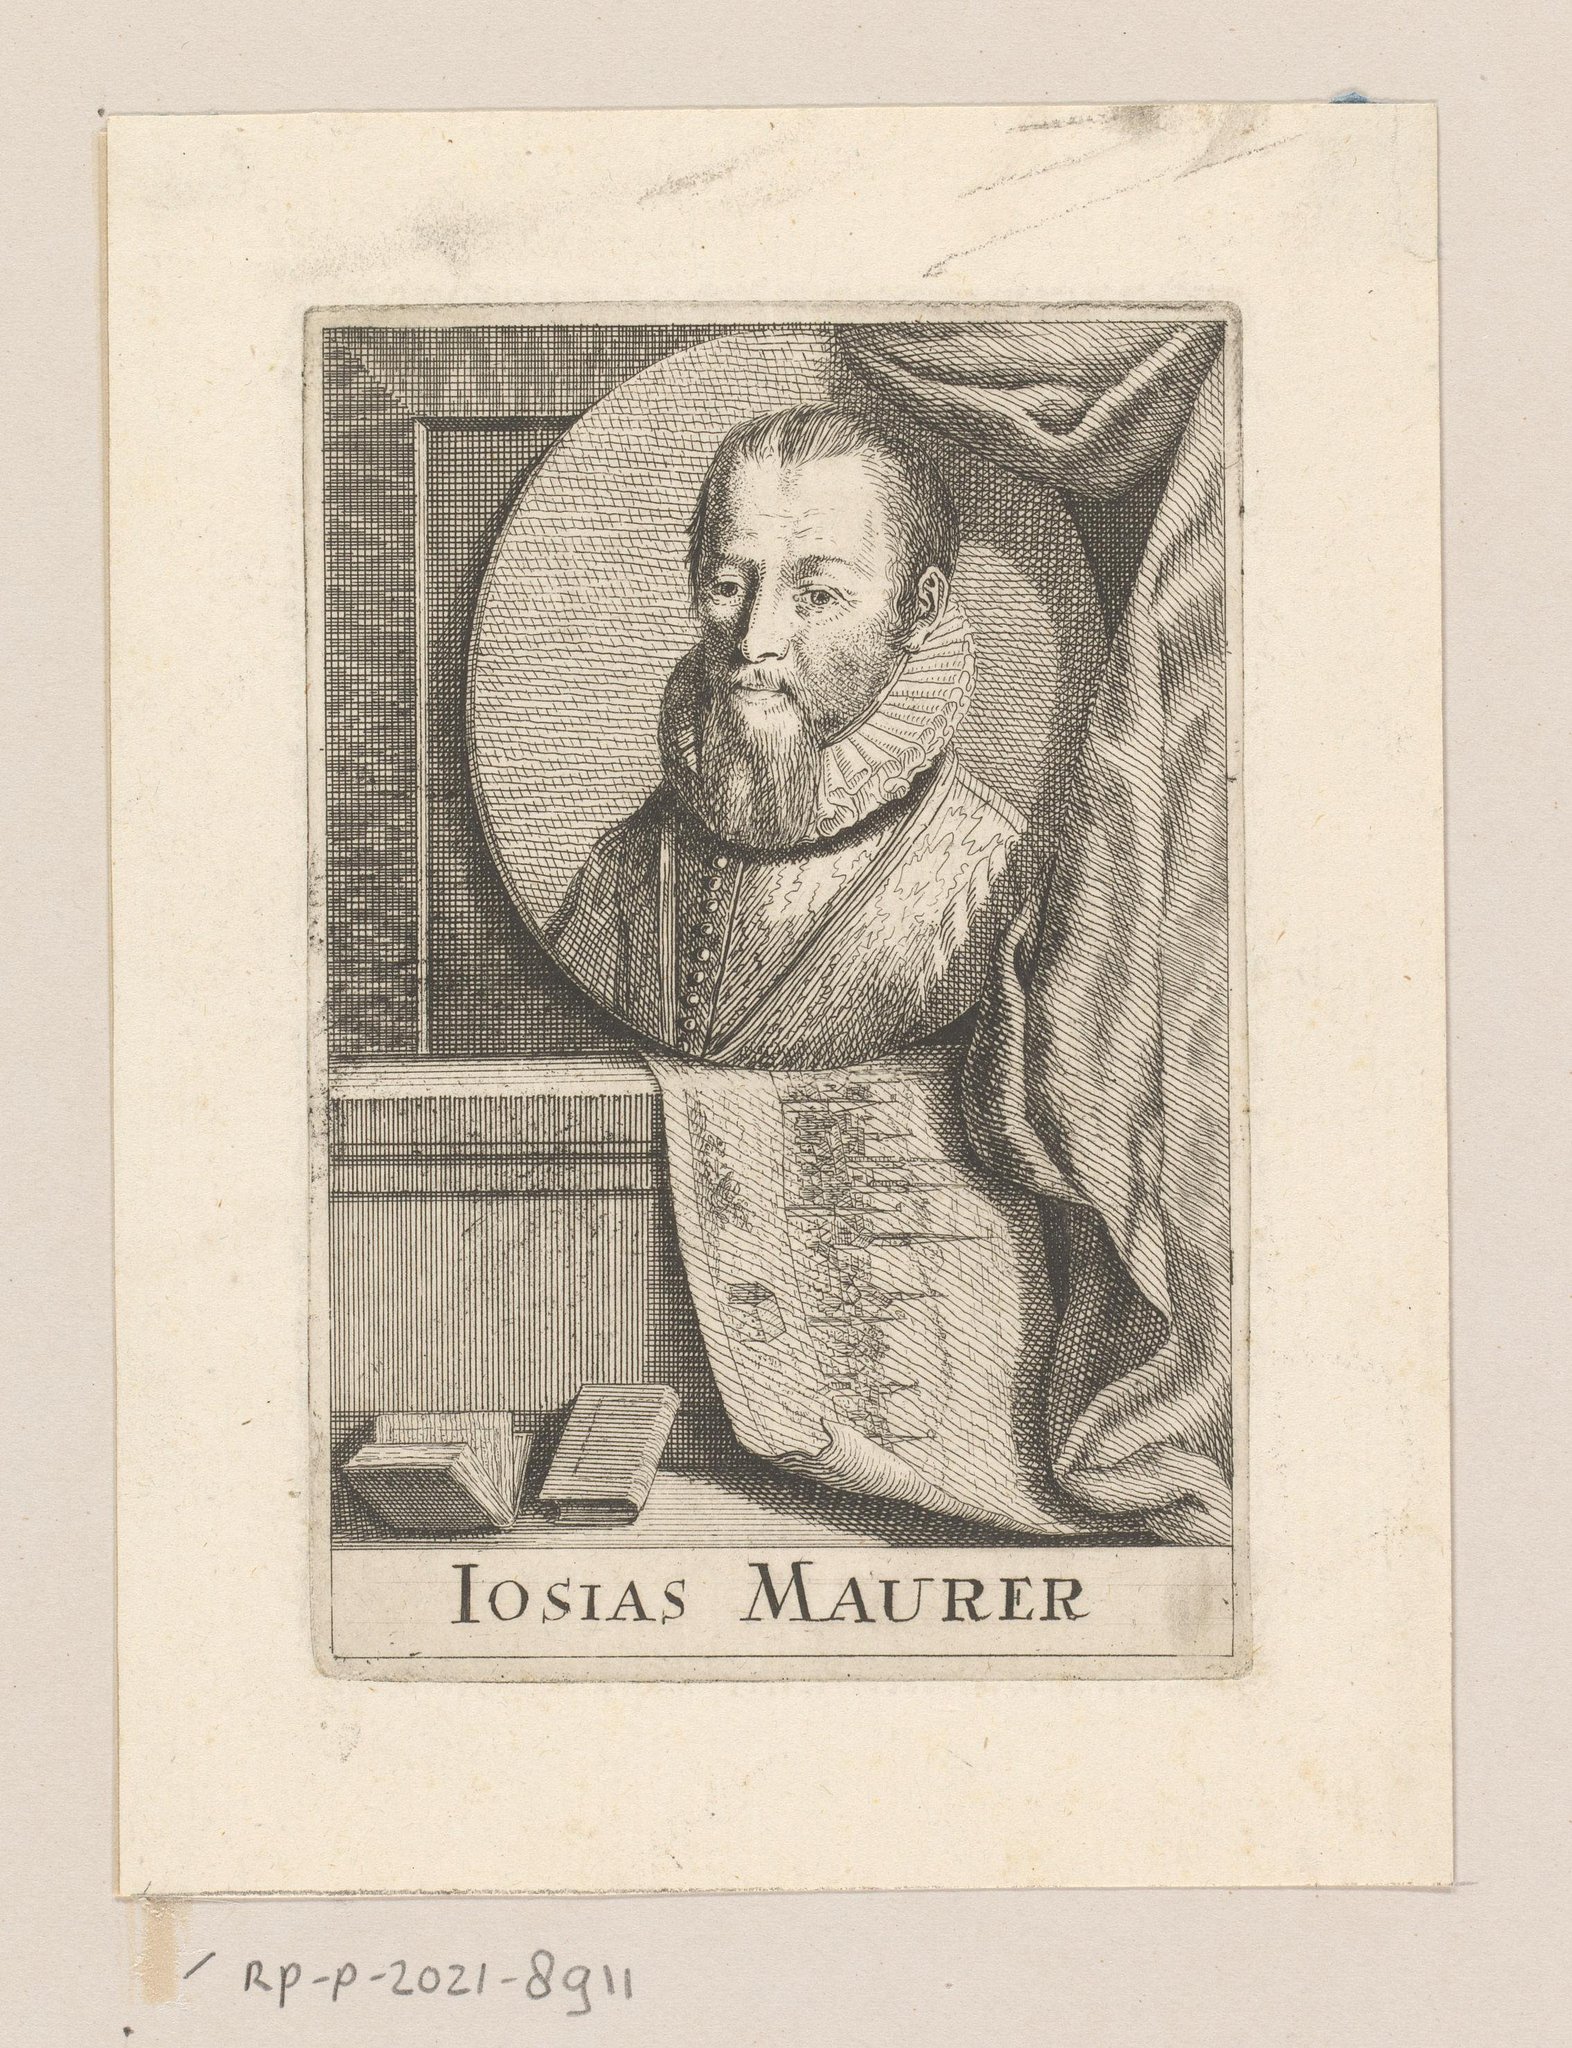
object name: print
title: Iosias Maurer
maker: Anonymous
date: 1769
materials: paper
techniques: etching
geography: switzerland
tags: city-view, and landscape with man-made constructions, historical persons, portrait, self-portrait of painter, book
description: Prent waarschijnlijk uit: Füssli, Johann Caspar. Geschichte des besten Künstler in der Schweiss (...). Zürich: Orell, Gessner & Co., 1769.